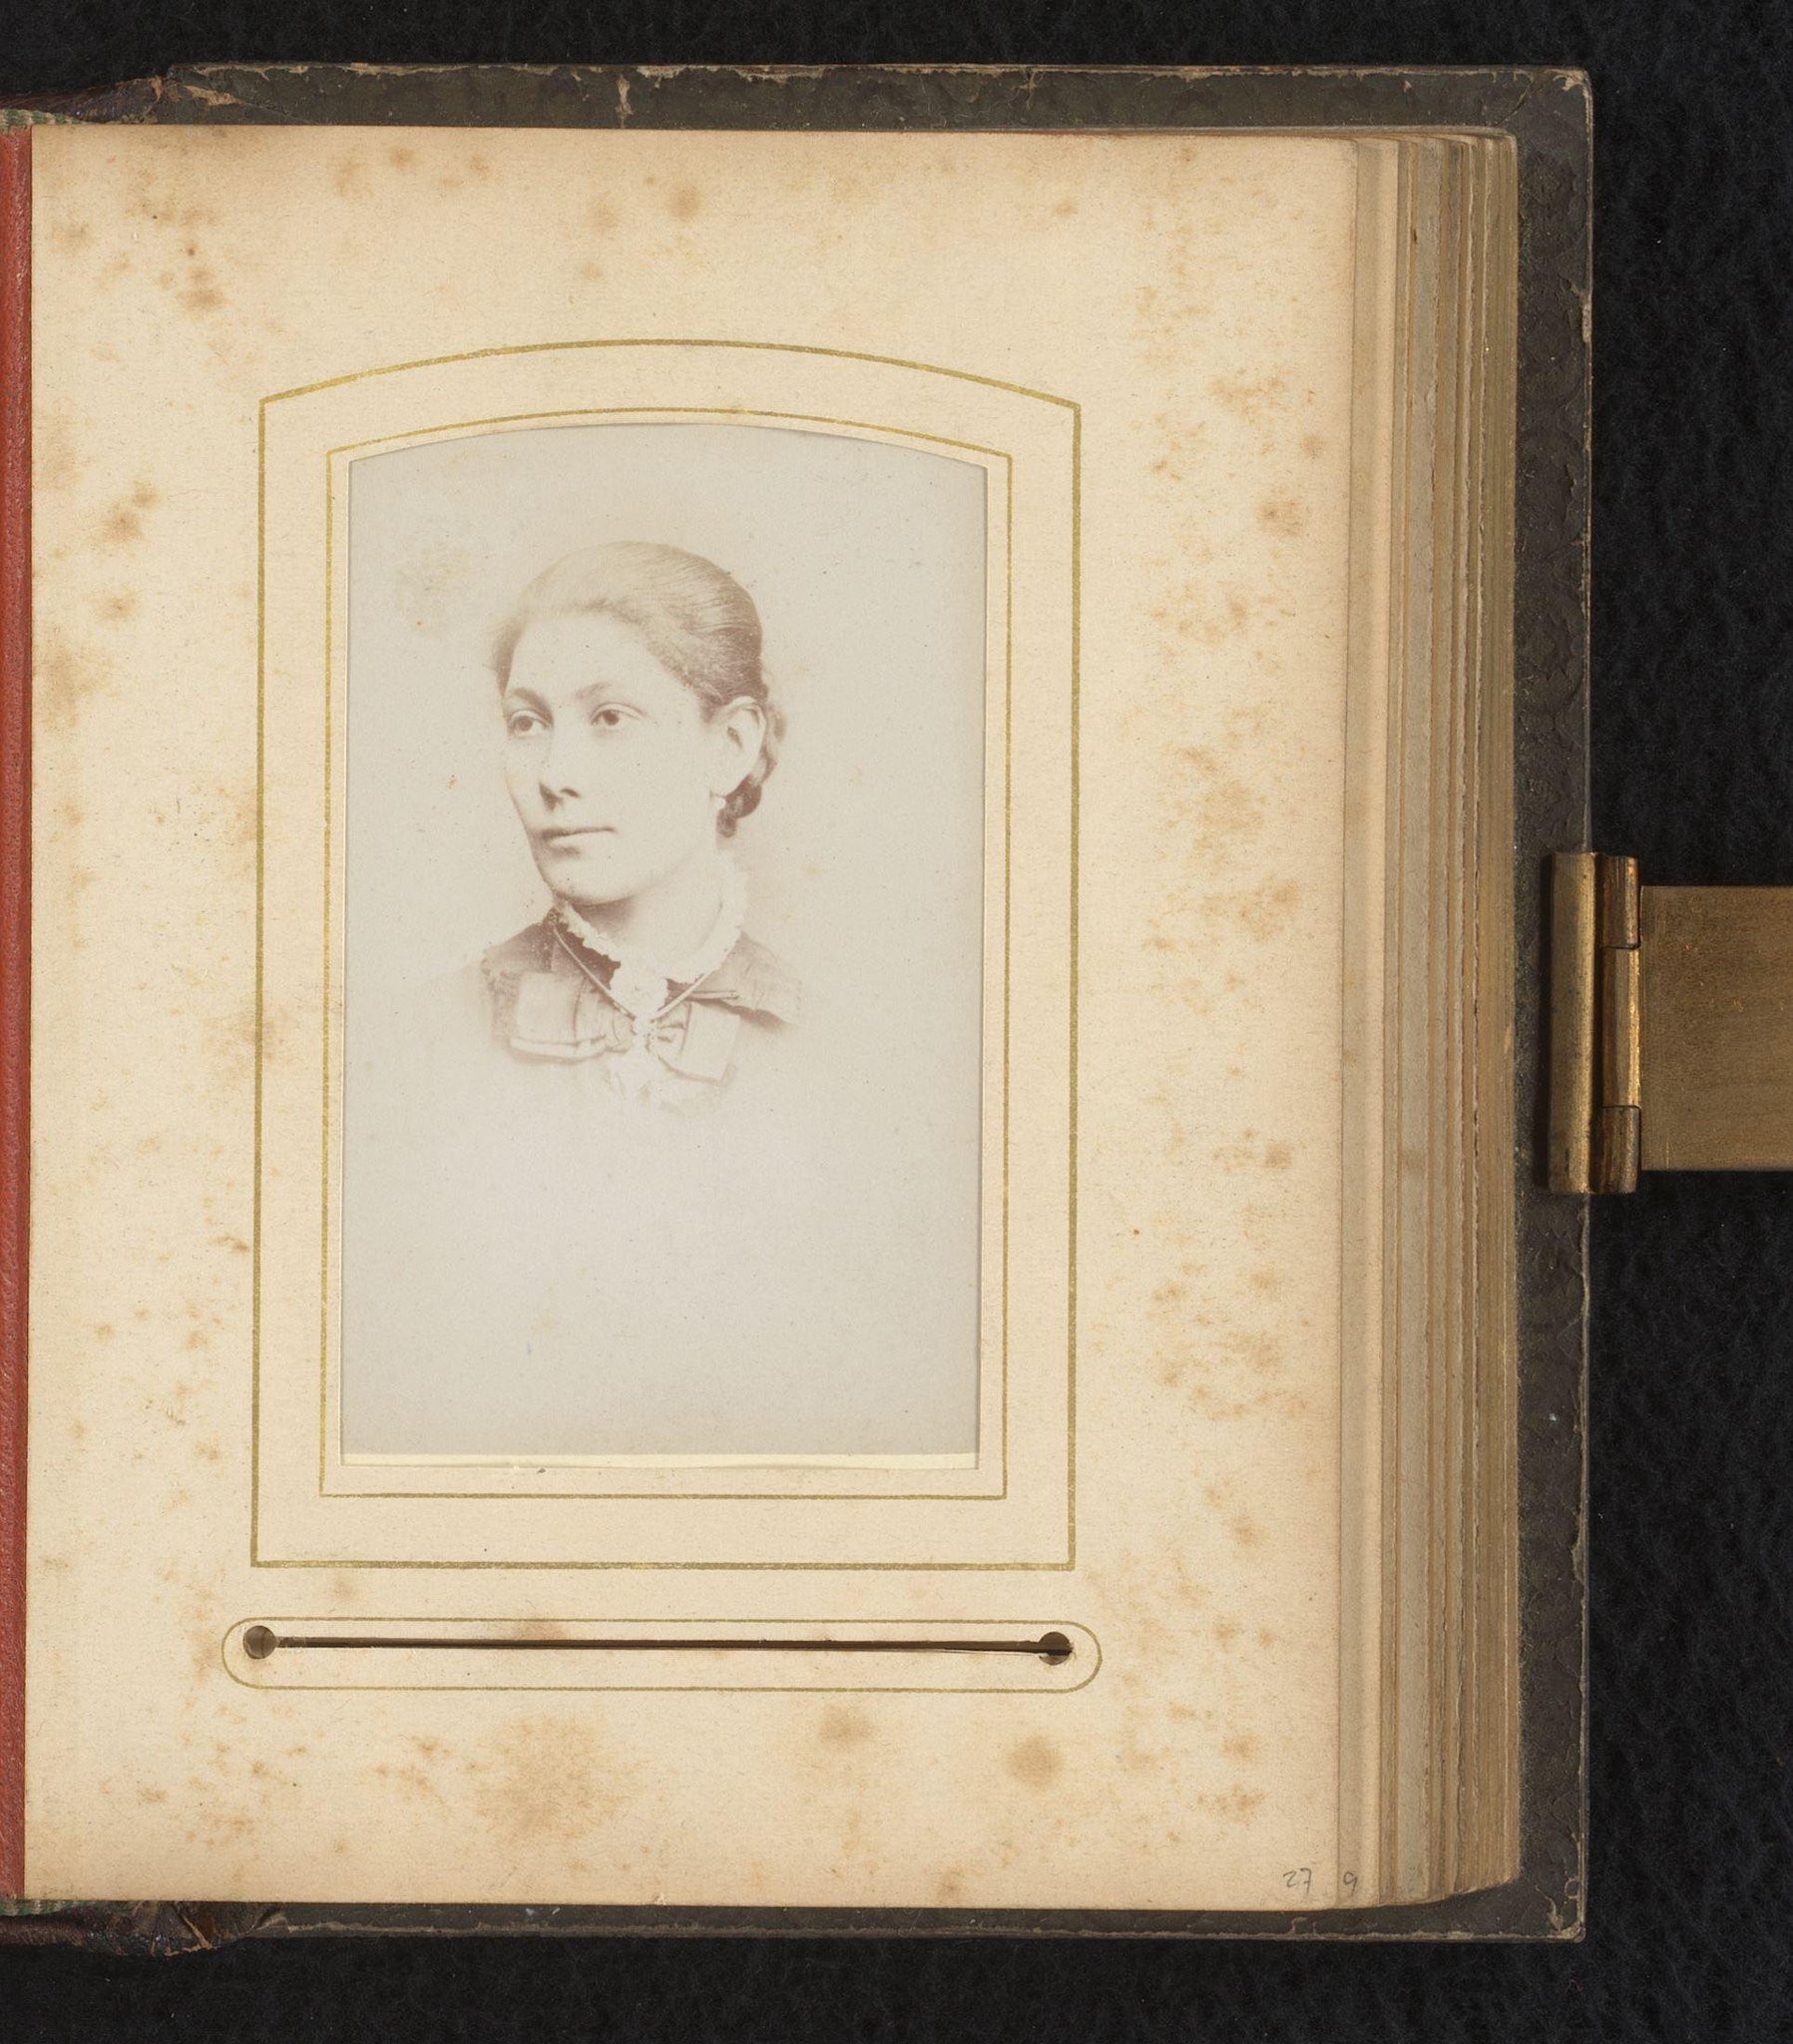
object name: album leaf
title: Portret van een vrouw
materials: cardboard, photographic support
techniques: albumen print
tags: adult woman, historical persons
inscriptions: number: ‘493-01’, inscription: ‘Lock & Whitfield/ 178. Regent Street/London W./ and 109, Kings Road/ Brighton’